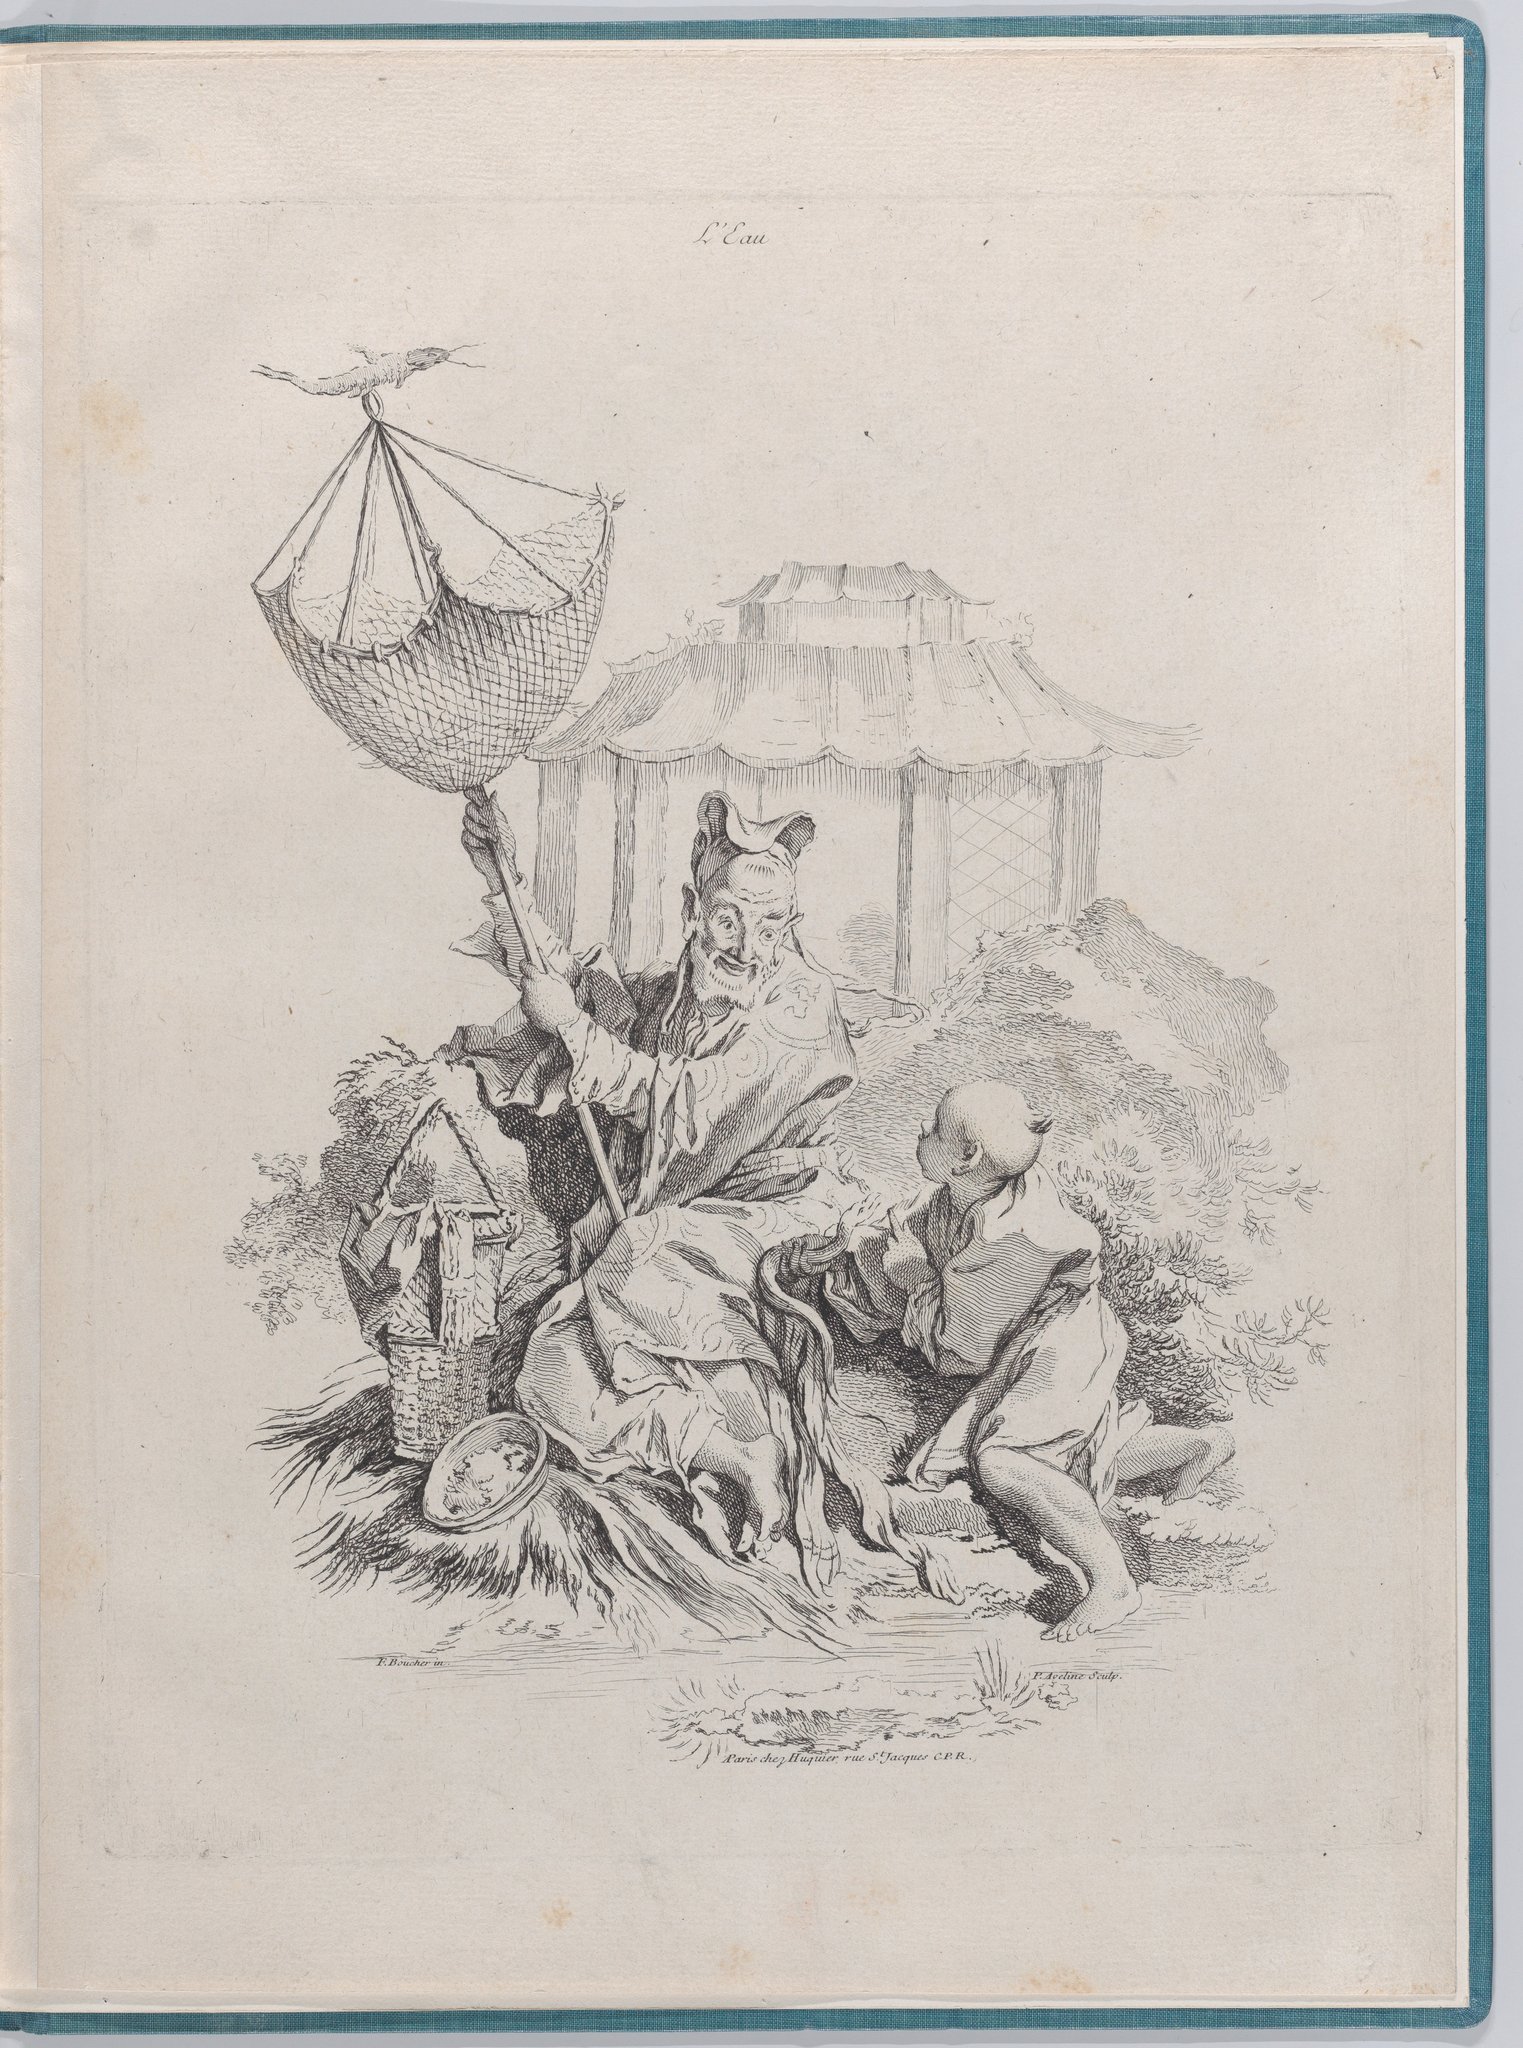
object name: print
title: Water, from The Four Elements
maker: pierre alexandre aveline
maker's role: artist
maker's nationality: french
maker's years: 1702-1760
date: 1738-1749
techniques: engraving, etching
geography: france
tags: chinoiserie,boys,men